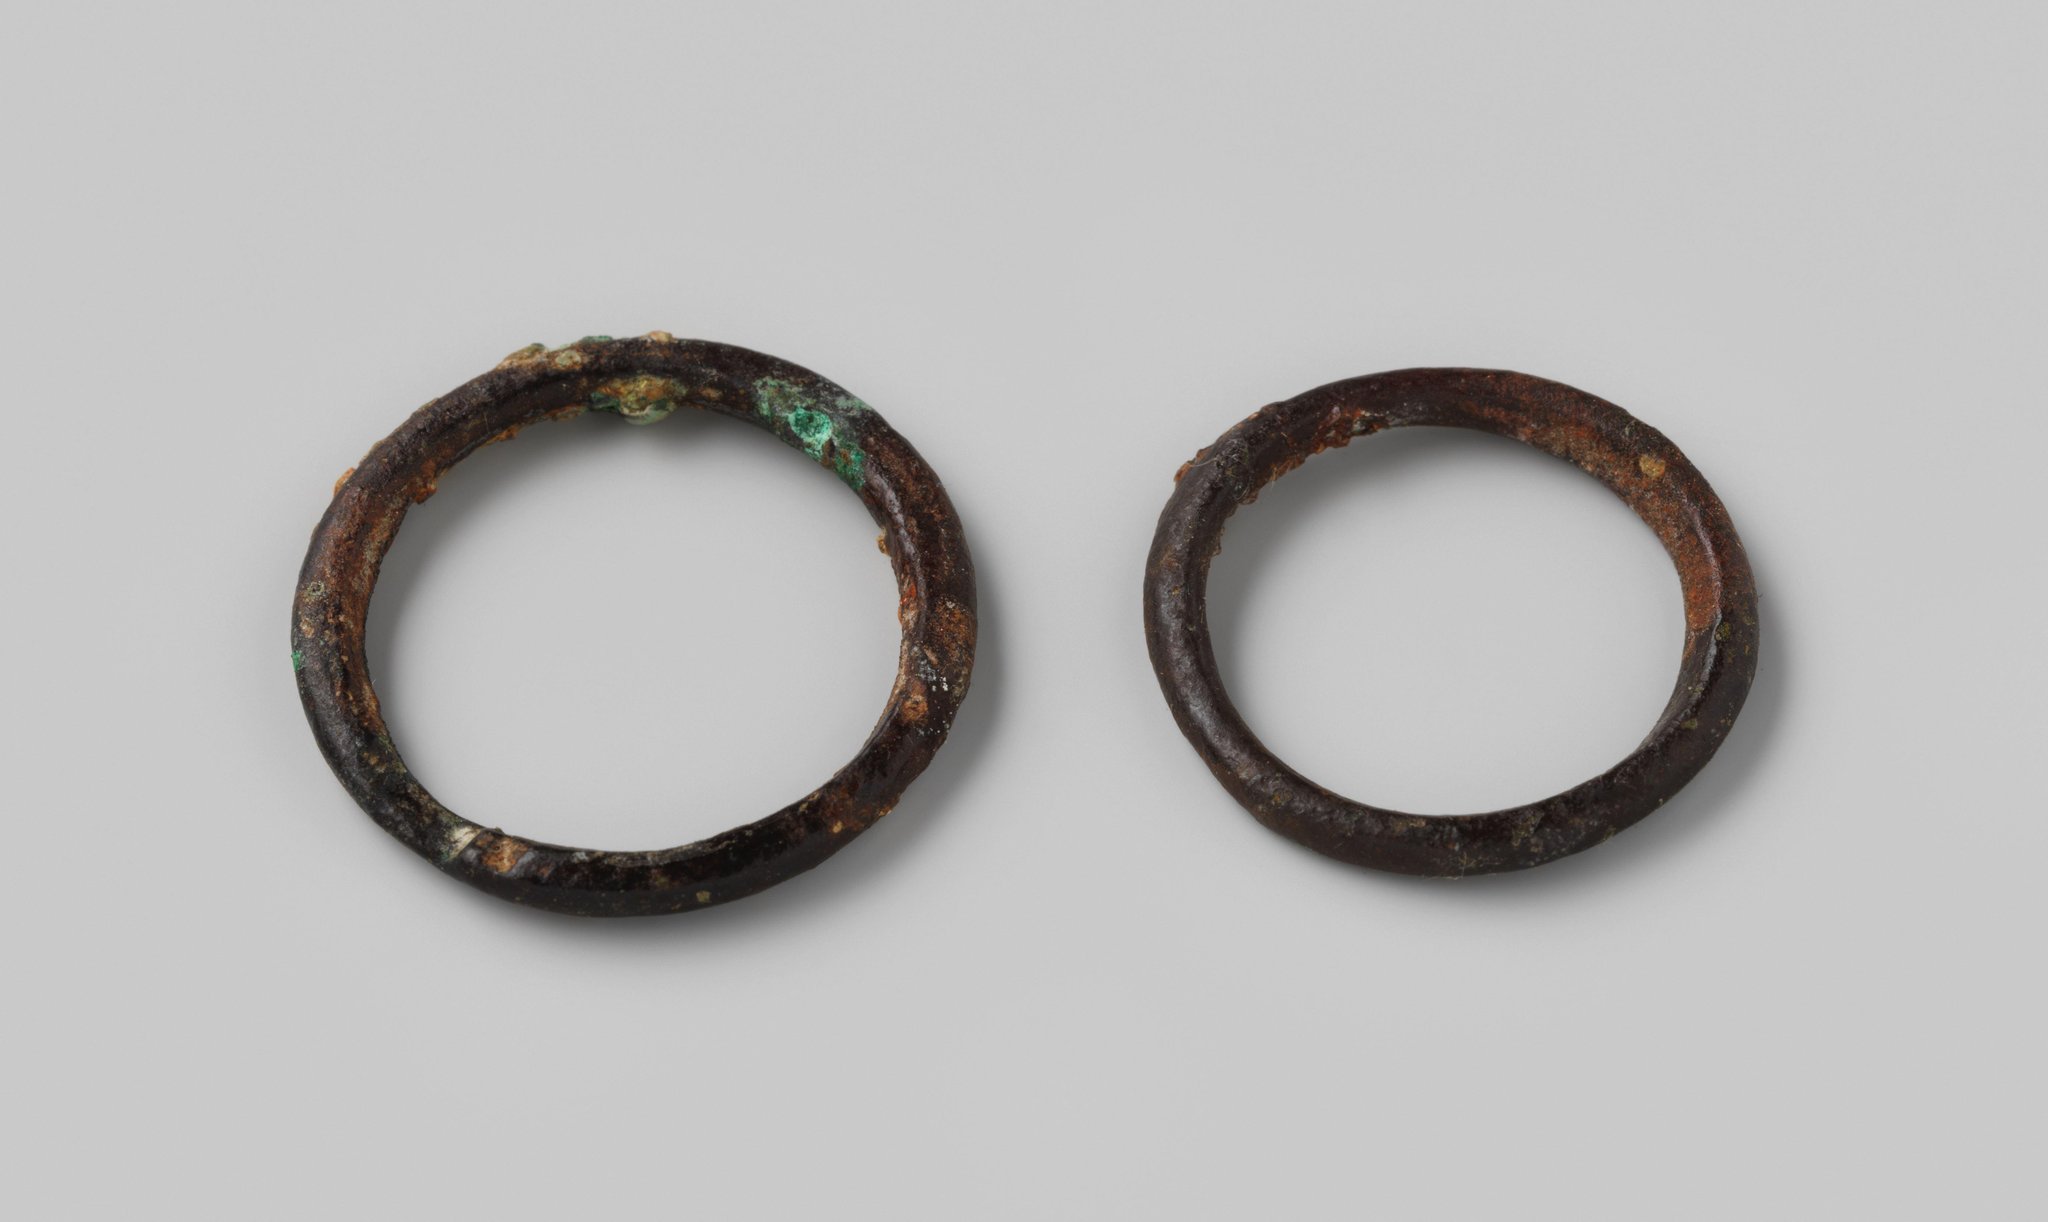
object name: ring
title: Ringvormige fragmenten uit het wrak van de Oost-Indiëvaarder Hollandia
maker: Anonymous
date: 1700-1743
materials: copper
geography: netherlands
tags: verenigde oostindische compagnie, hollandia (schip), annet